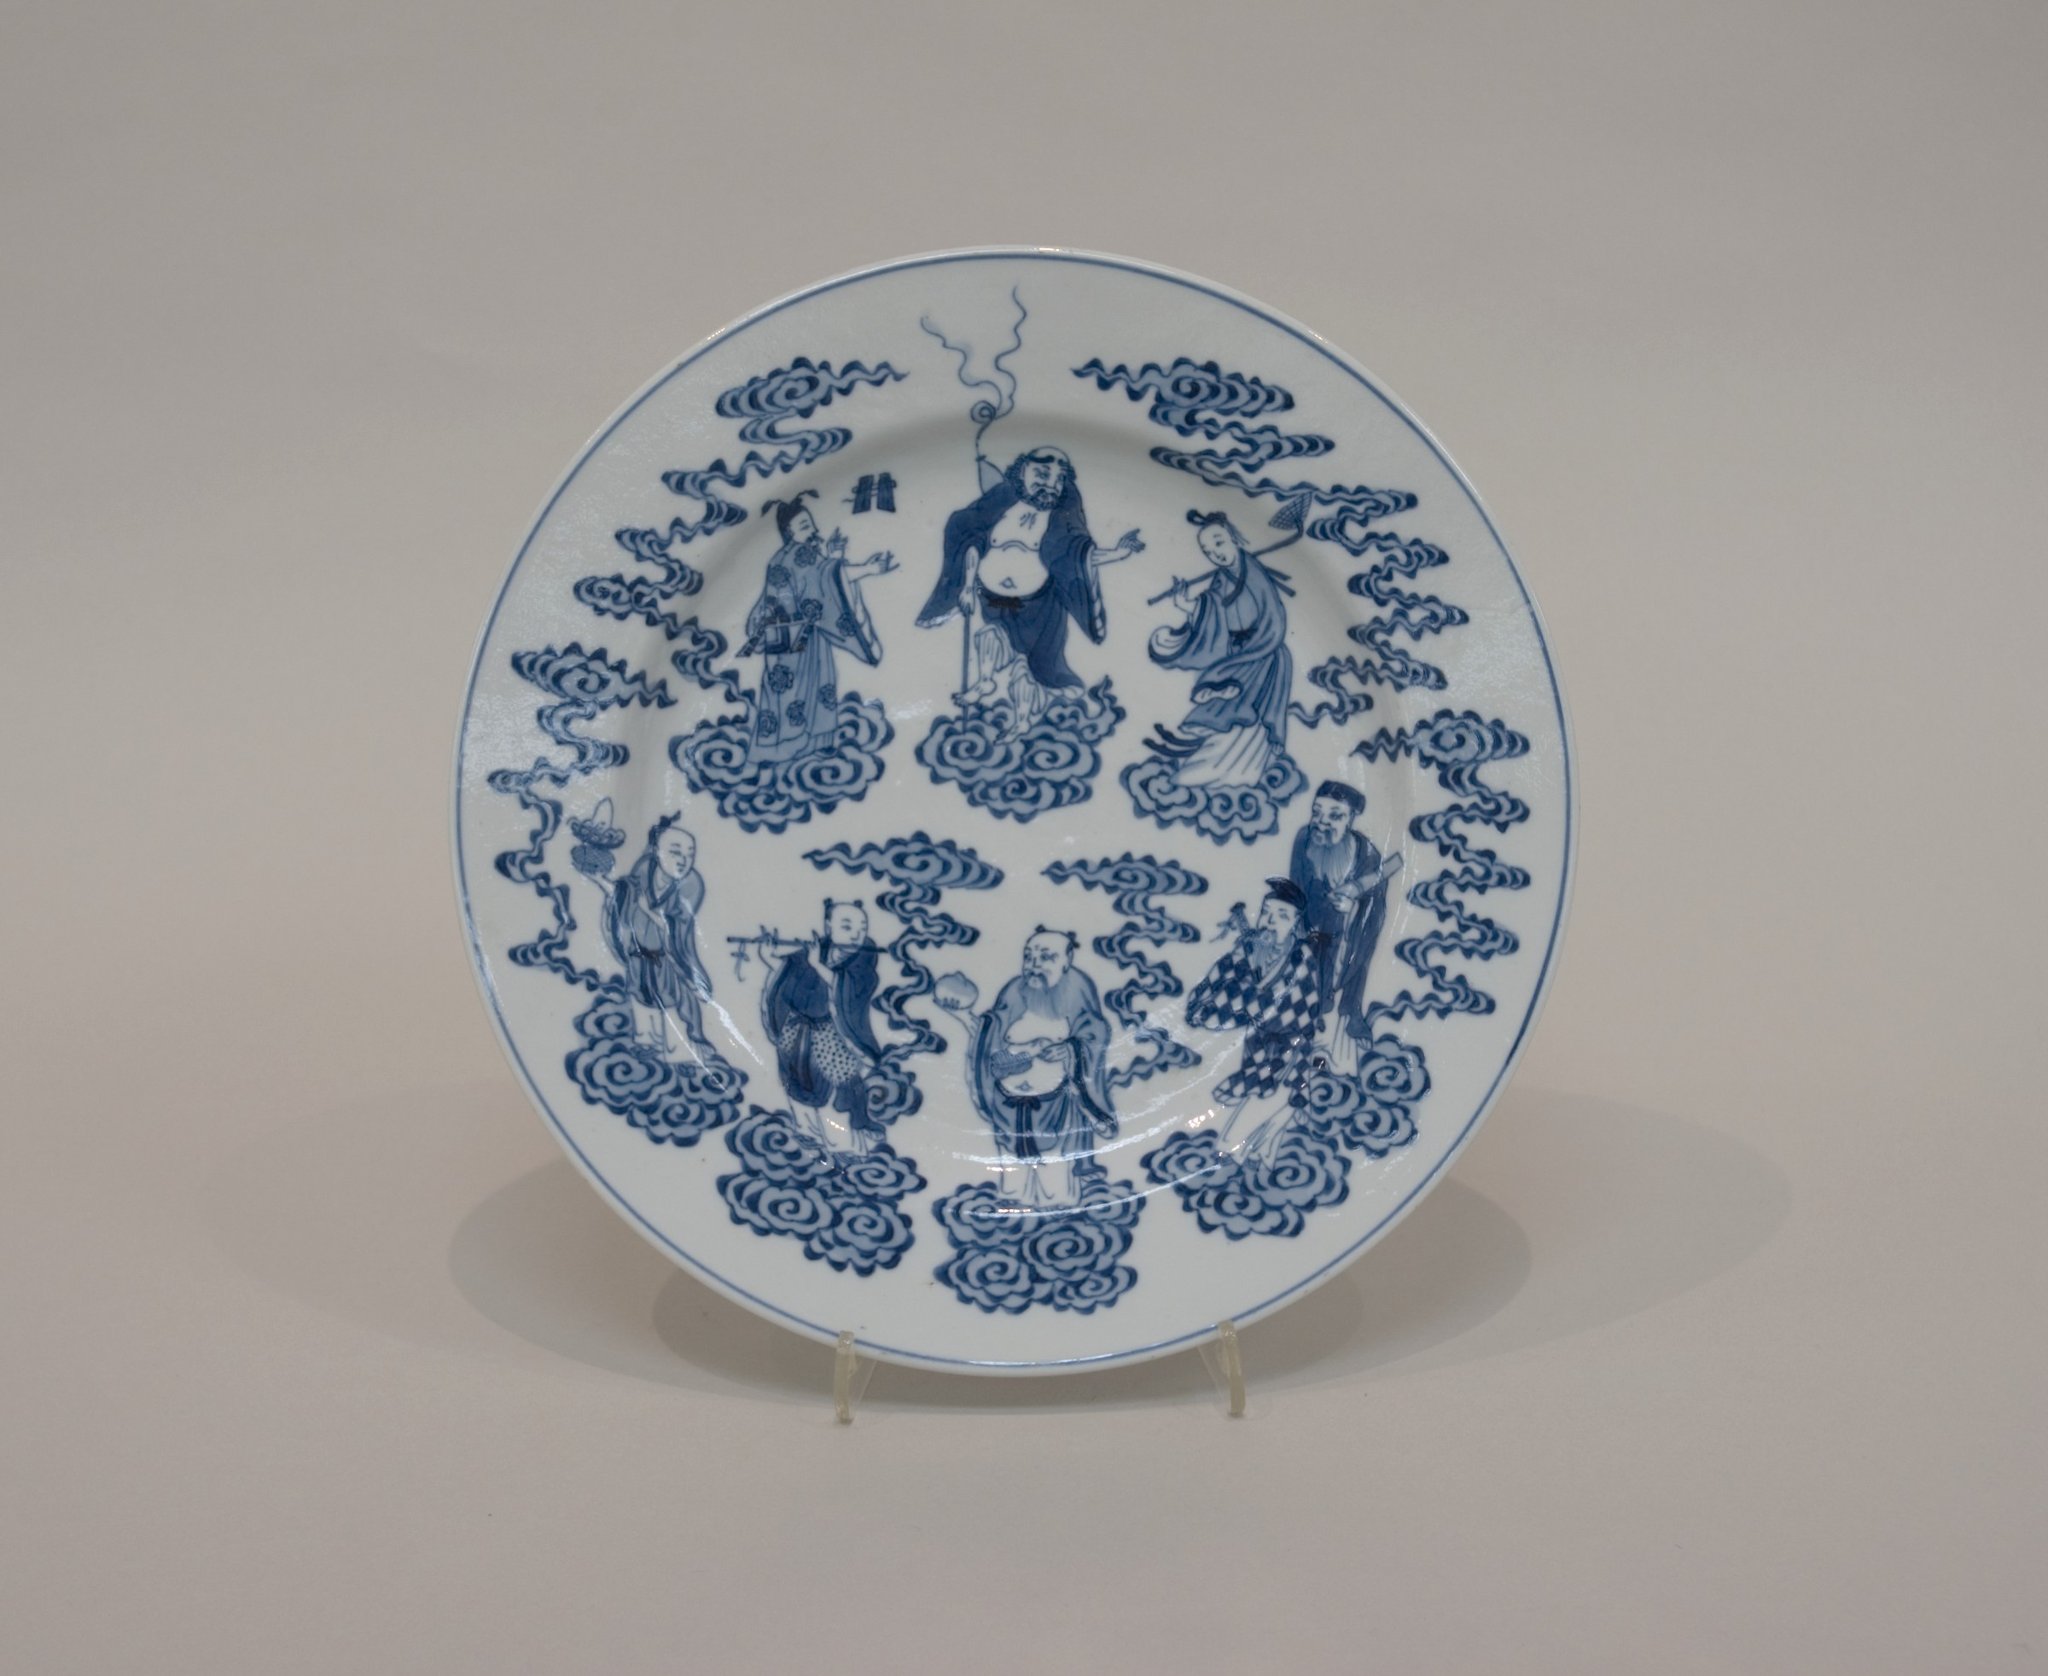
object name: plate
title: Plate with the Eight Immortals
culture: chinese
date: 1701-1800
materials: cobalt, porcelain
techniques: painting, underglaze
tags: musical instruments,men